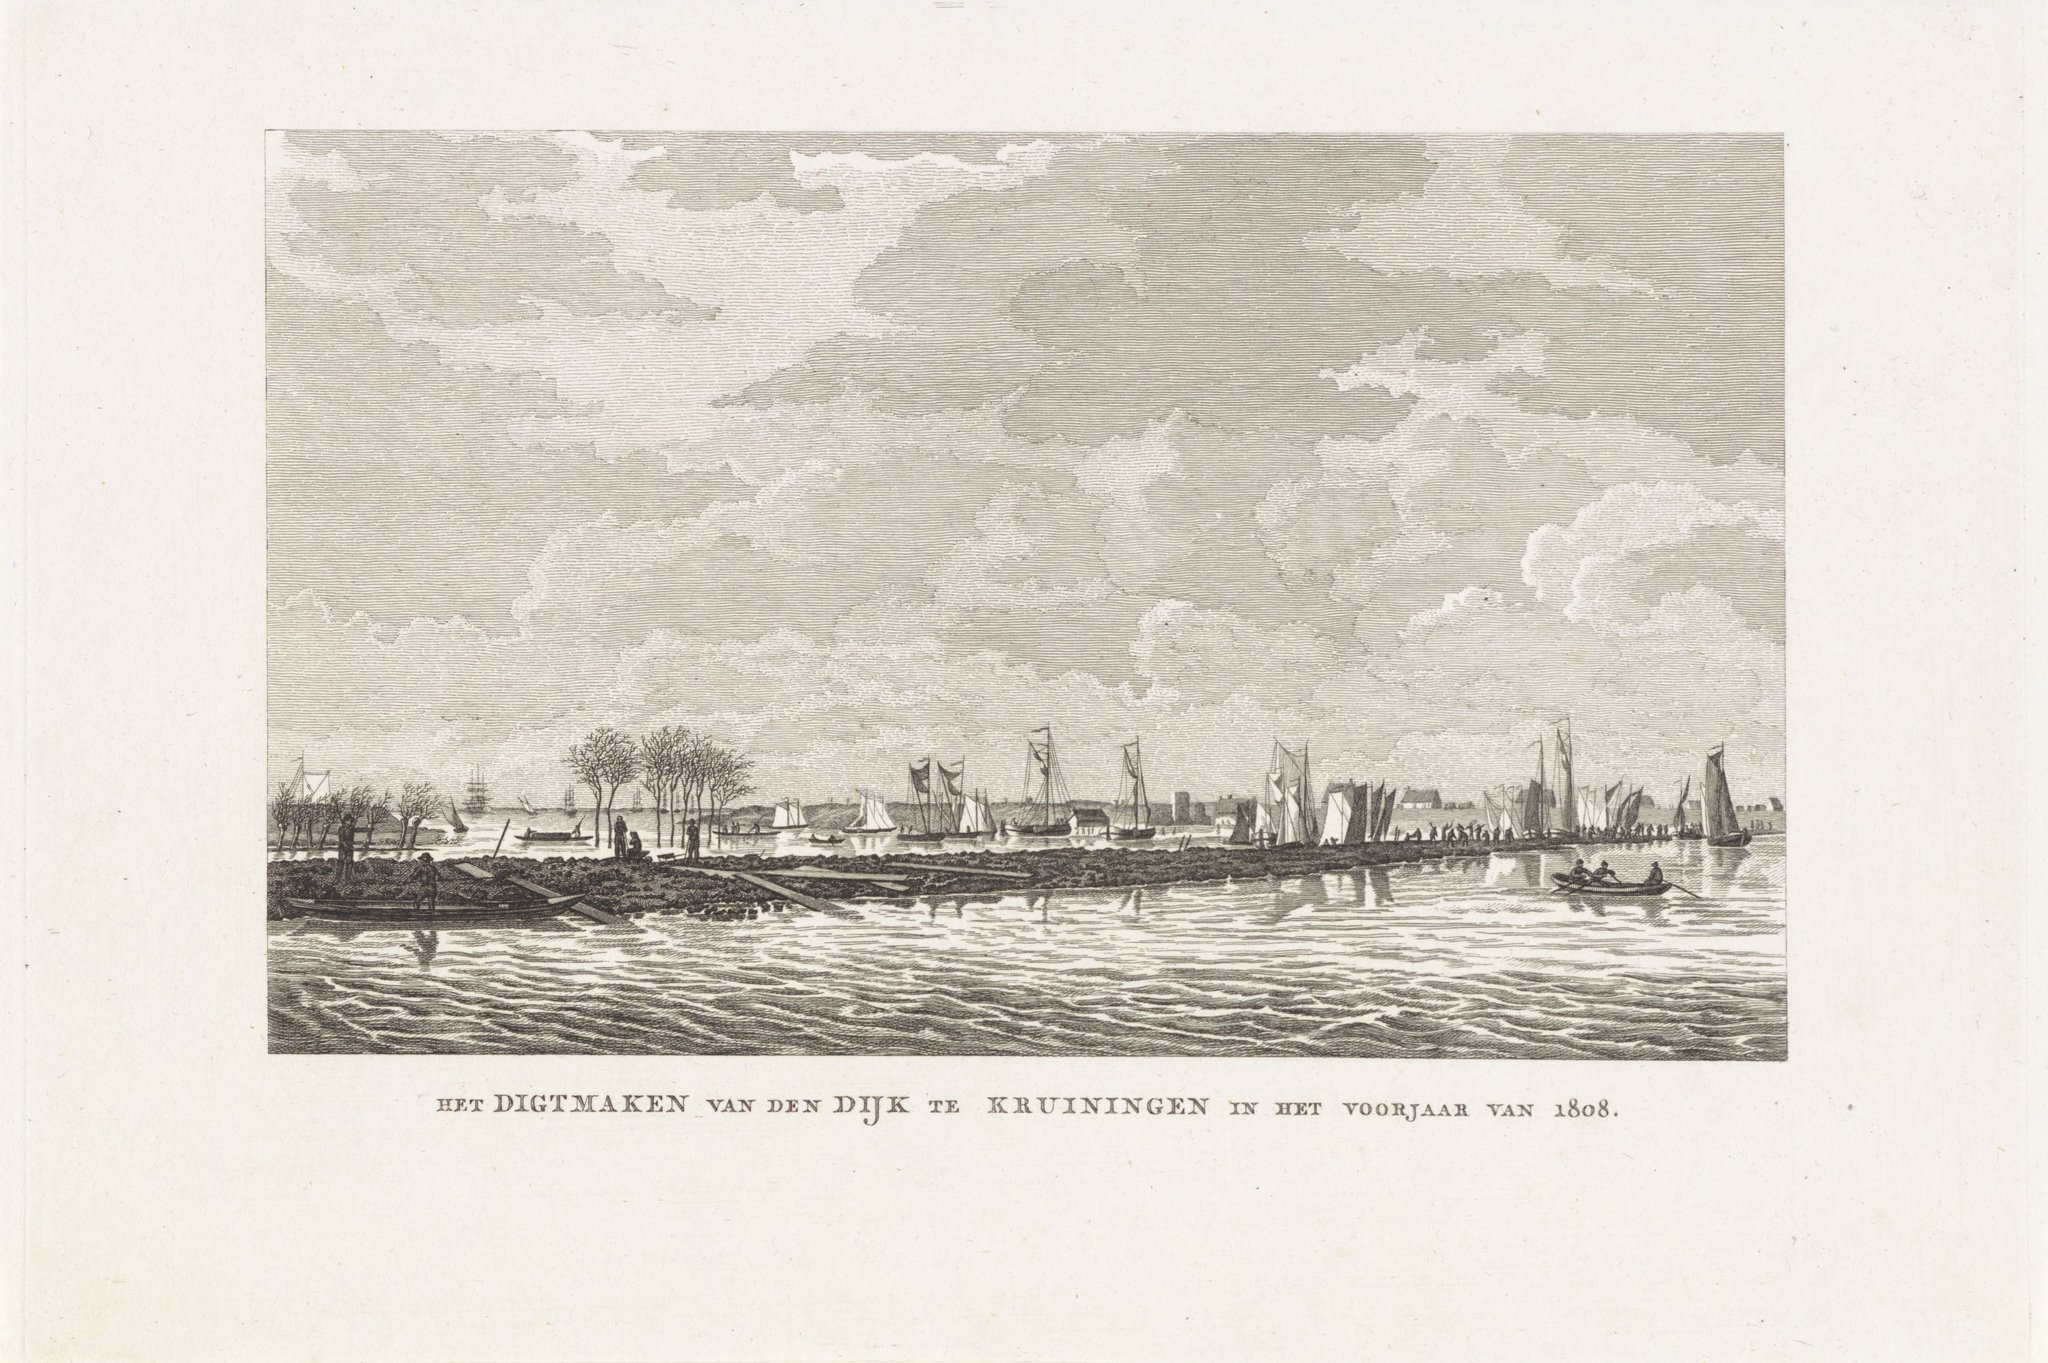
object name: print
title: Overstroming te Kruiningen, 1808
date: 1808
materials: paper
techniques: etching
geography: haarlem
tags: flood, flushing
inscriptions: collector's mark: Lugt Lugt 2228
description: Prent gebruikt in: Hoek, S. van. Natuur- en geschiedkundige beschrijving van den verschrikkelijken watervloed tusschen den XIVden en XVden van Louwmaand des jaars 1808. Haarlem: Adriaan Pietersz. Loosjes, 1808.